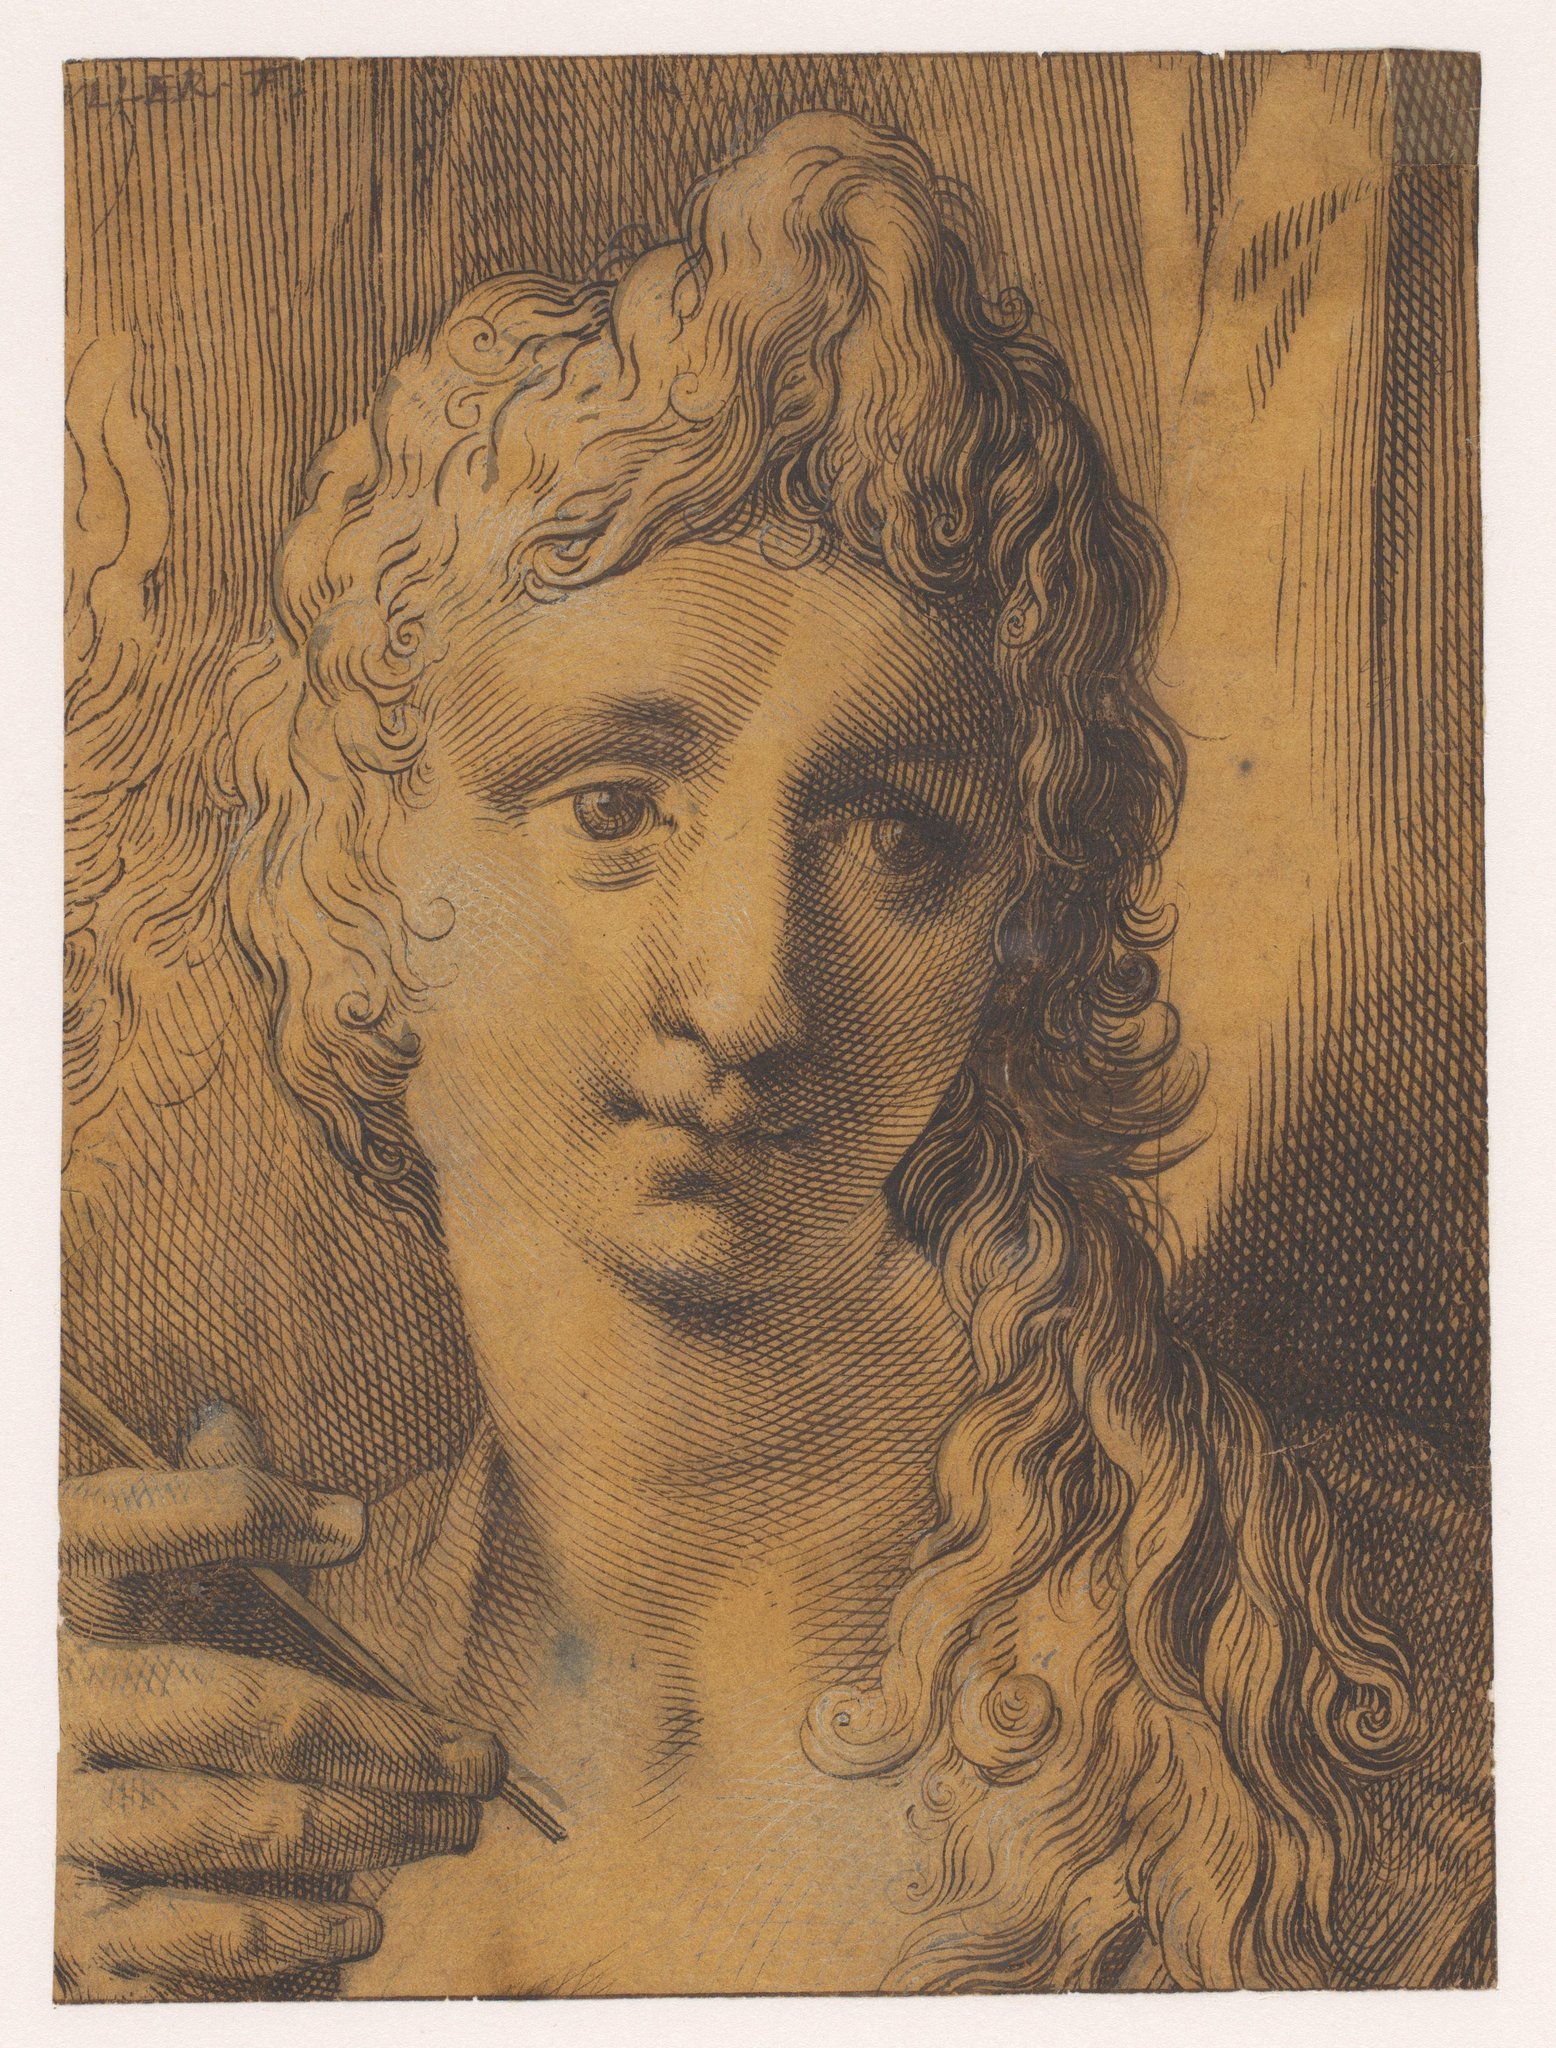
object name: drawing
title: Kop van een jongeling of jonge vrouw die een burijn (?) in de hand houdt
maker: jan harmensz. muller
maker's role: draughtsman, print maker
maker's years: 1571-1628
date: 1615-1625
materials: ink, paint, paper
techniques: pen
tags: adolescent, young woman, maiden, head (human), tools, implements of graphic artist (burin), youth, adolescent, head (human) - aa - female human figure